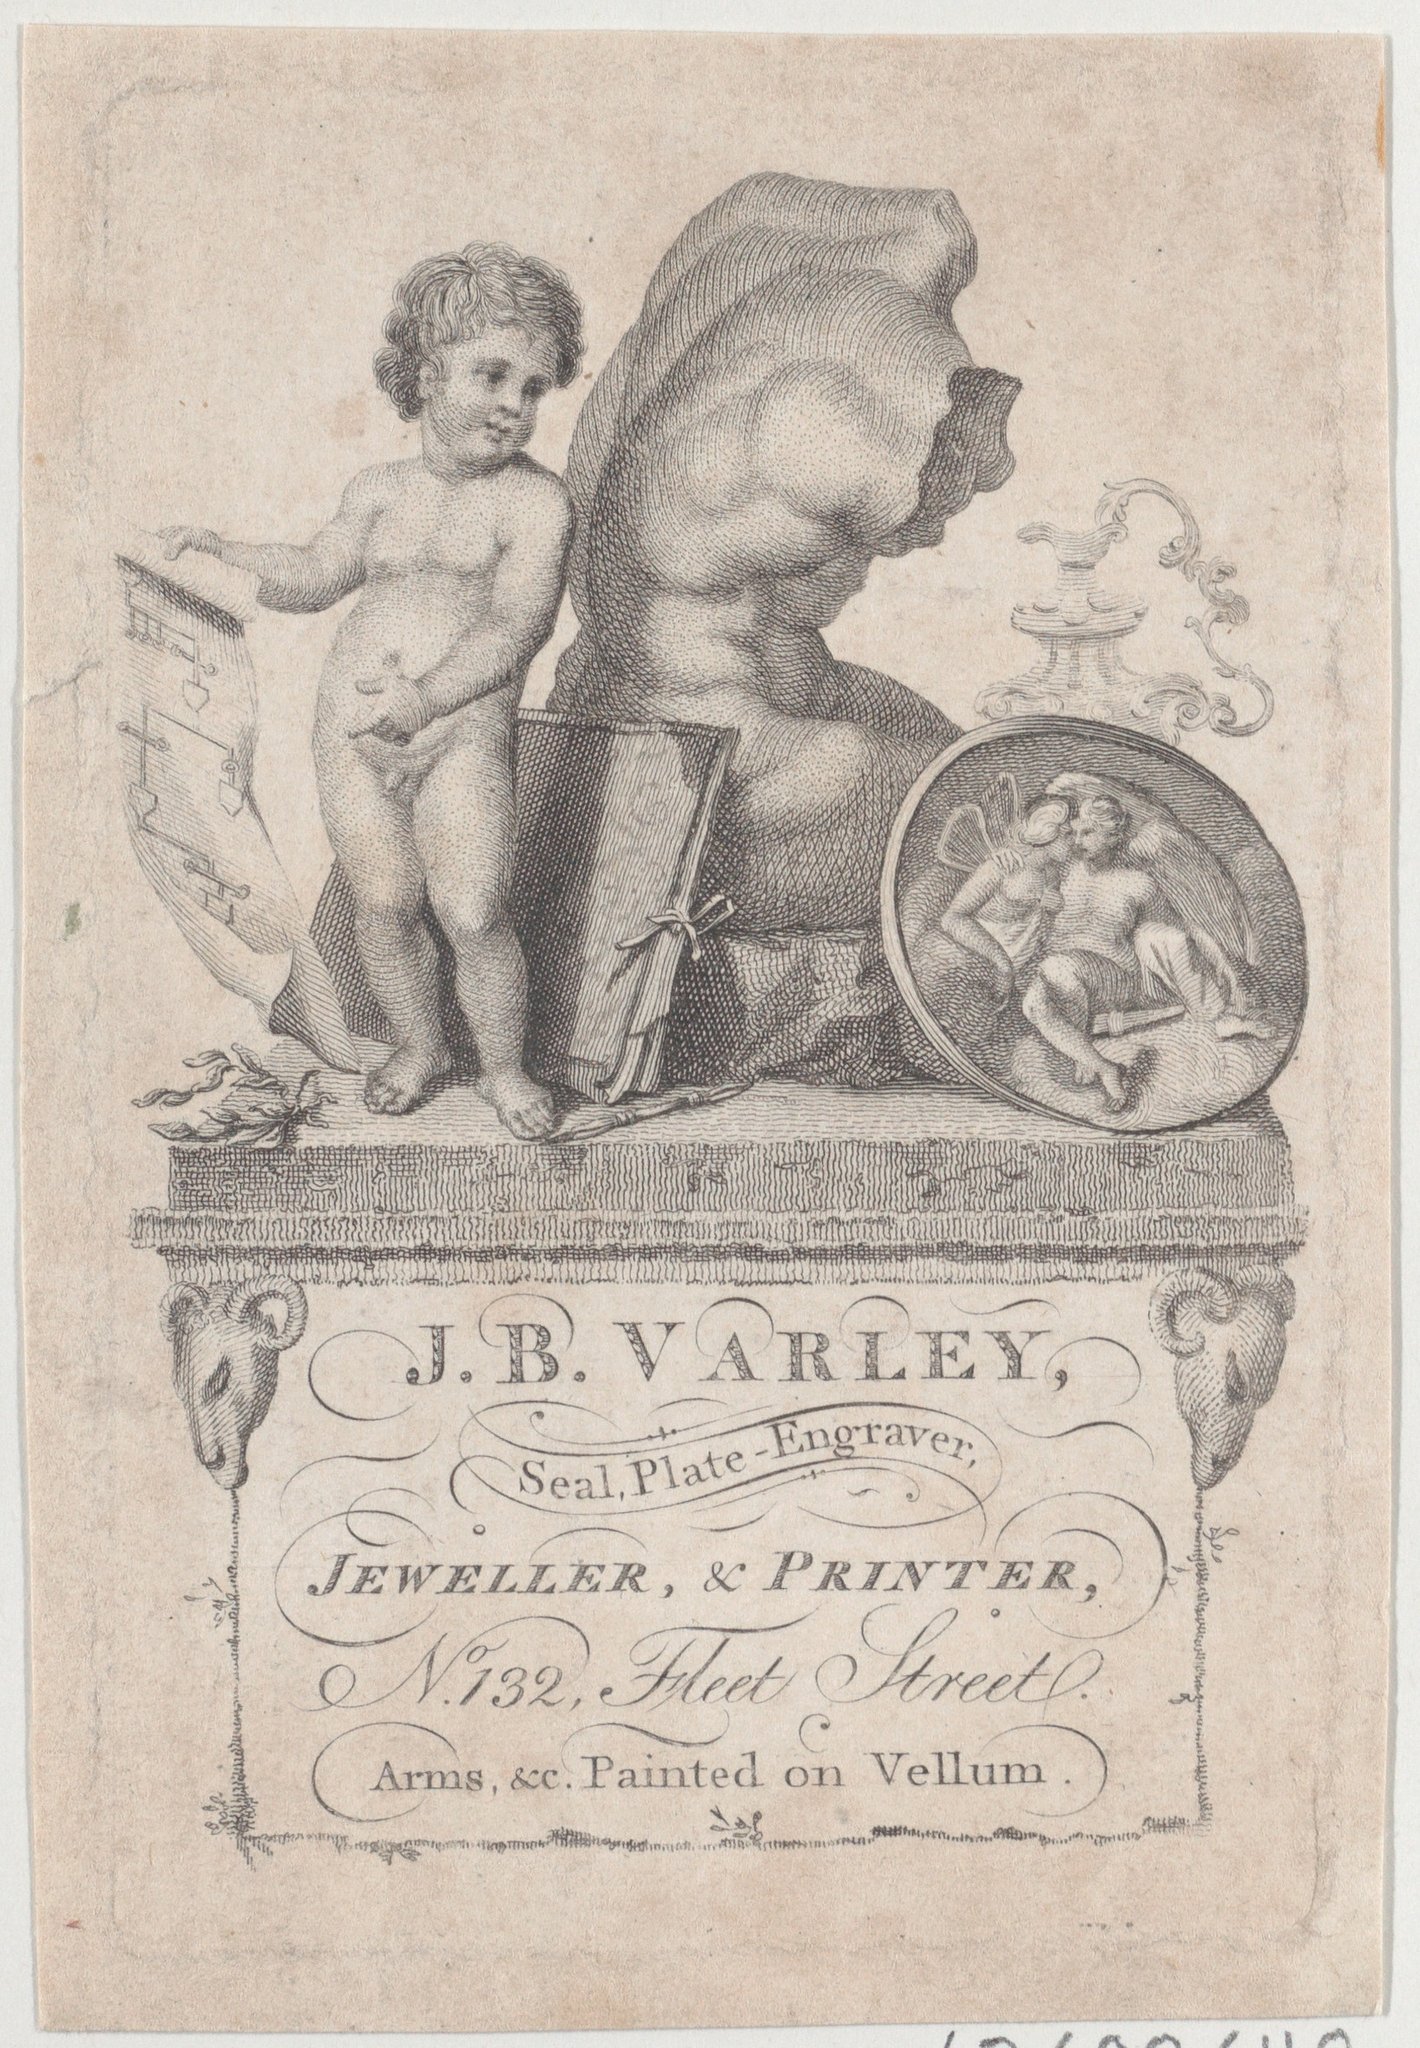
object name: print, trade card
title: Trade Card for J.B. Varley, Jeweller and Printer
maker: anonymous, british, 19th century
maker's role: artist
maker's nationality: british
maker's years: 1800-1900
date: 1801-1900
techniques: engraving